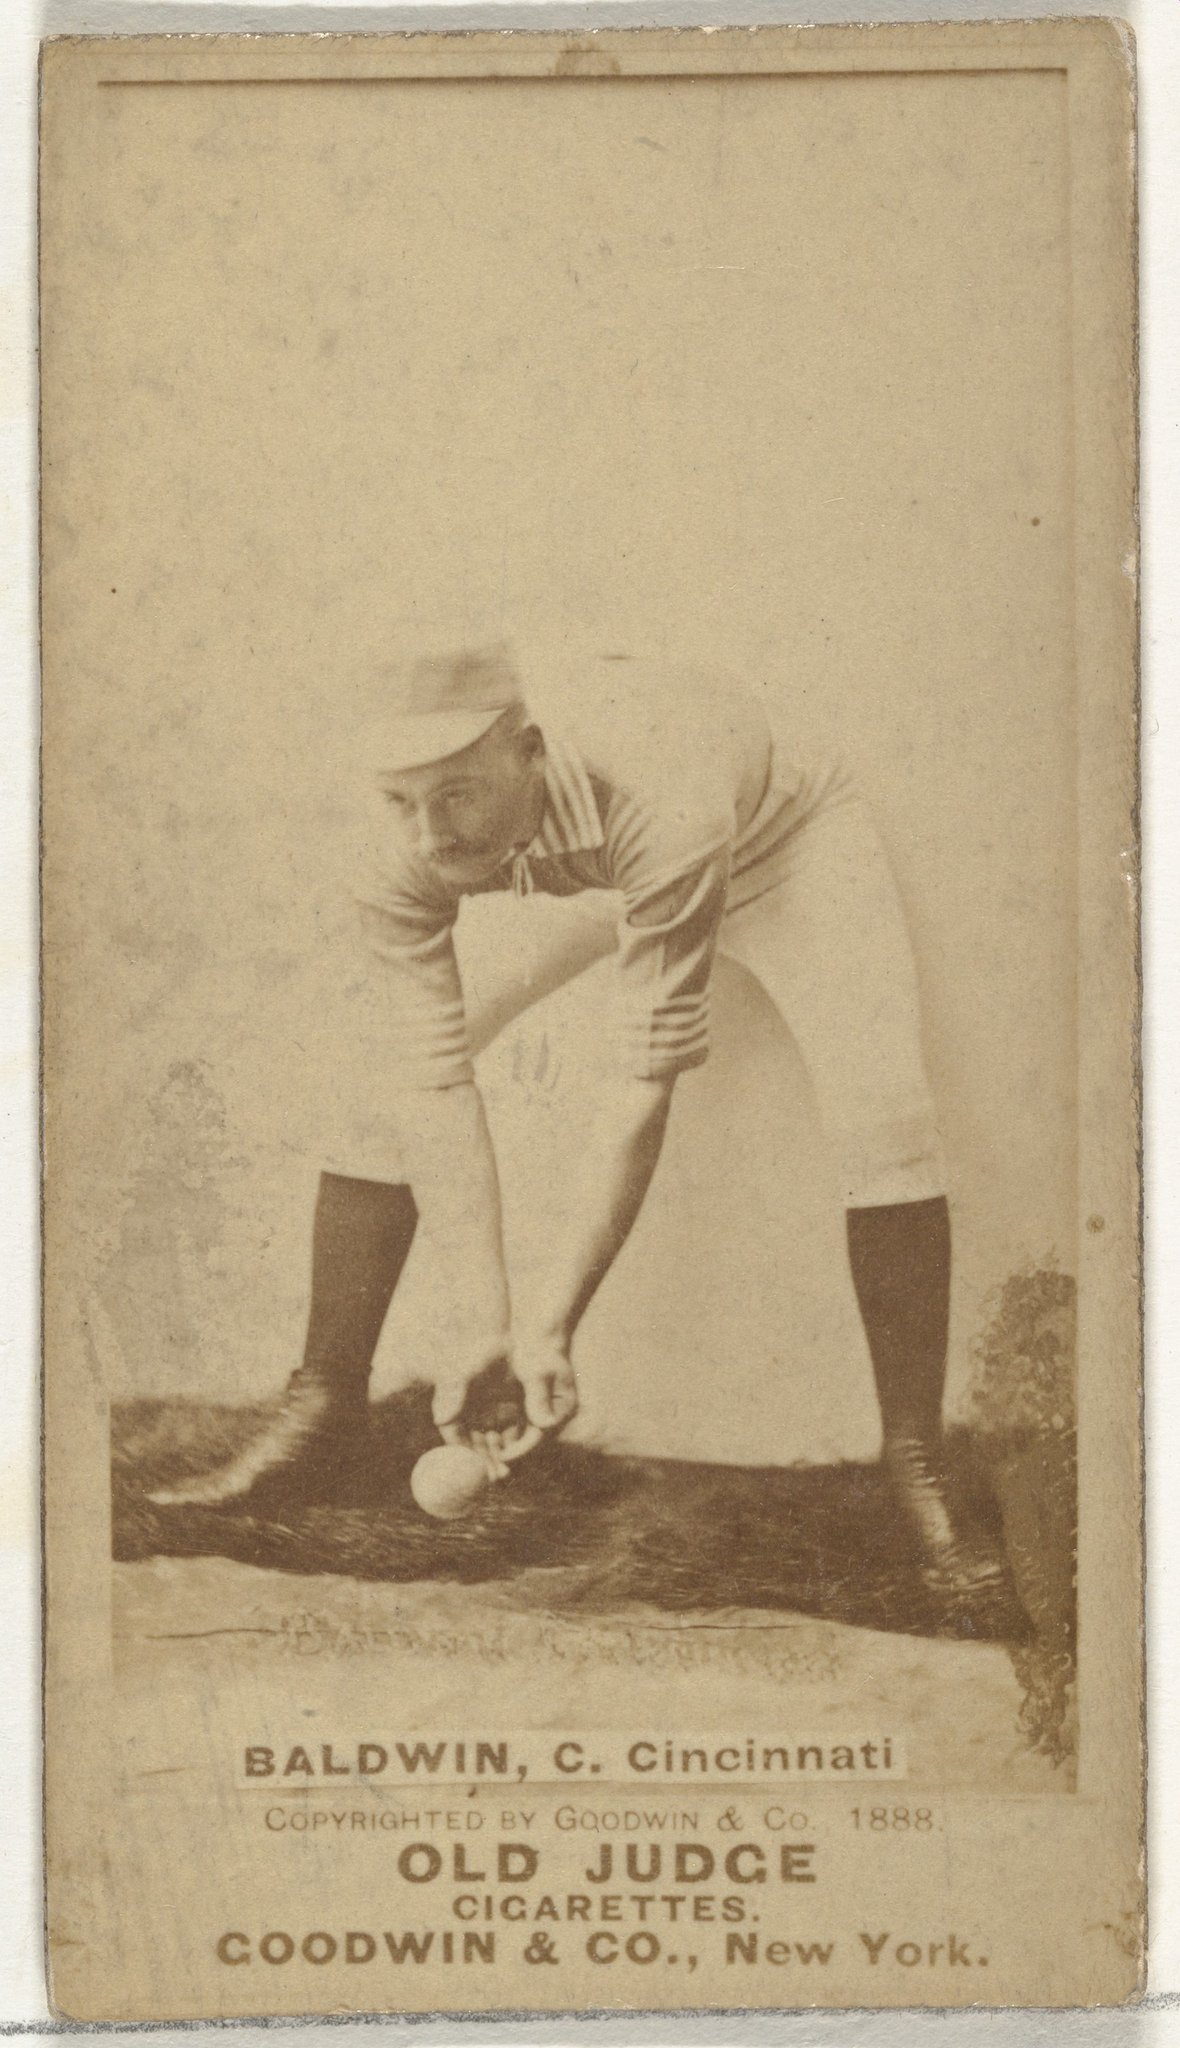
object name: baseball card, photograph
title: Clarence Geoghan "Kid" Baldwin, Catcher, Cincinnati, from the Old Judge series (N172) for Old Judge Cigarettes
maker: goodwin & company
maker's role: publisher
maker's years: 1850-1950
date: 1888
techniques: albumen silver print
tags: men,portraits,baseball,athletes